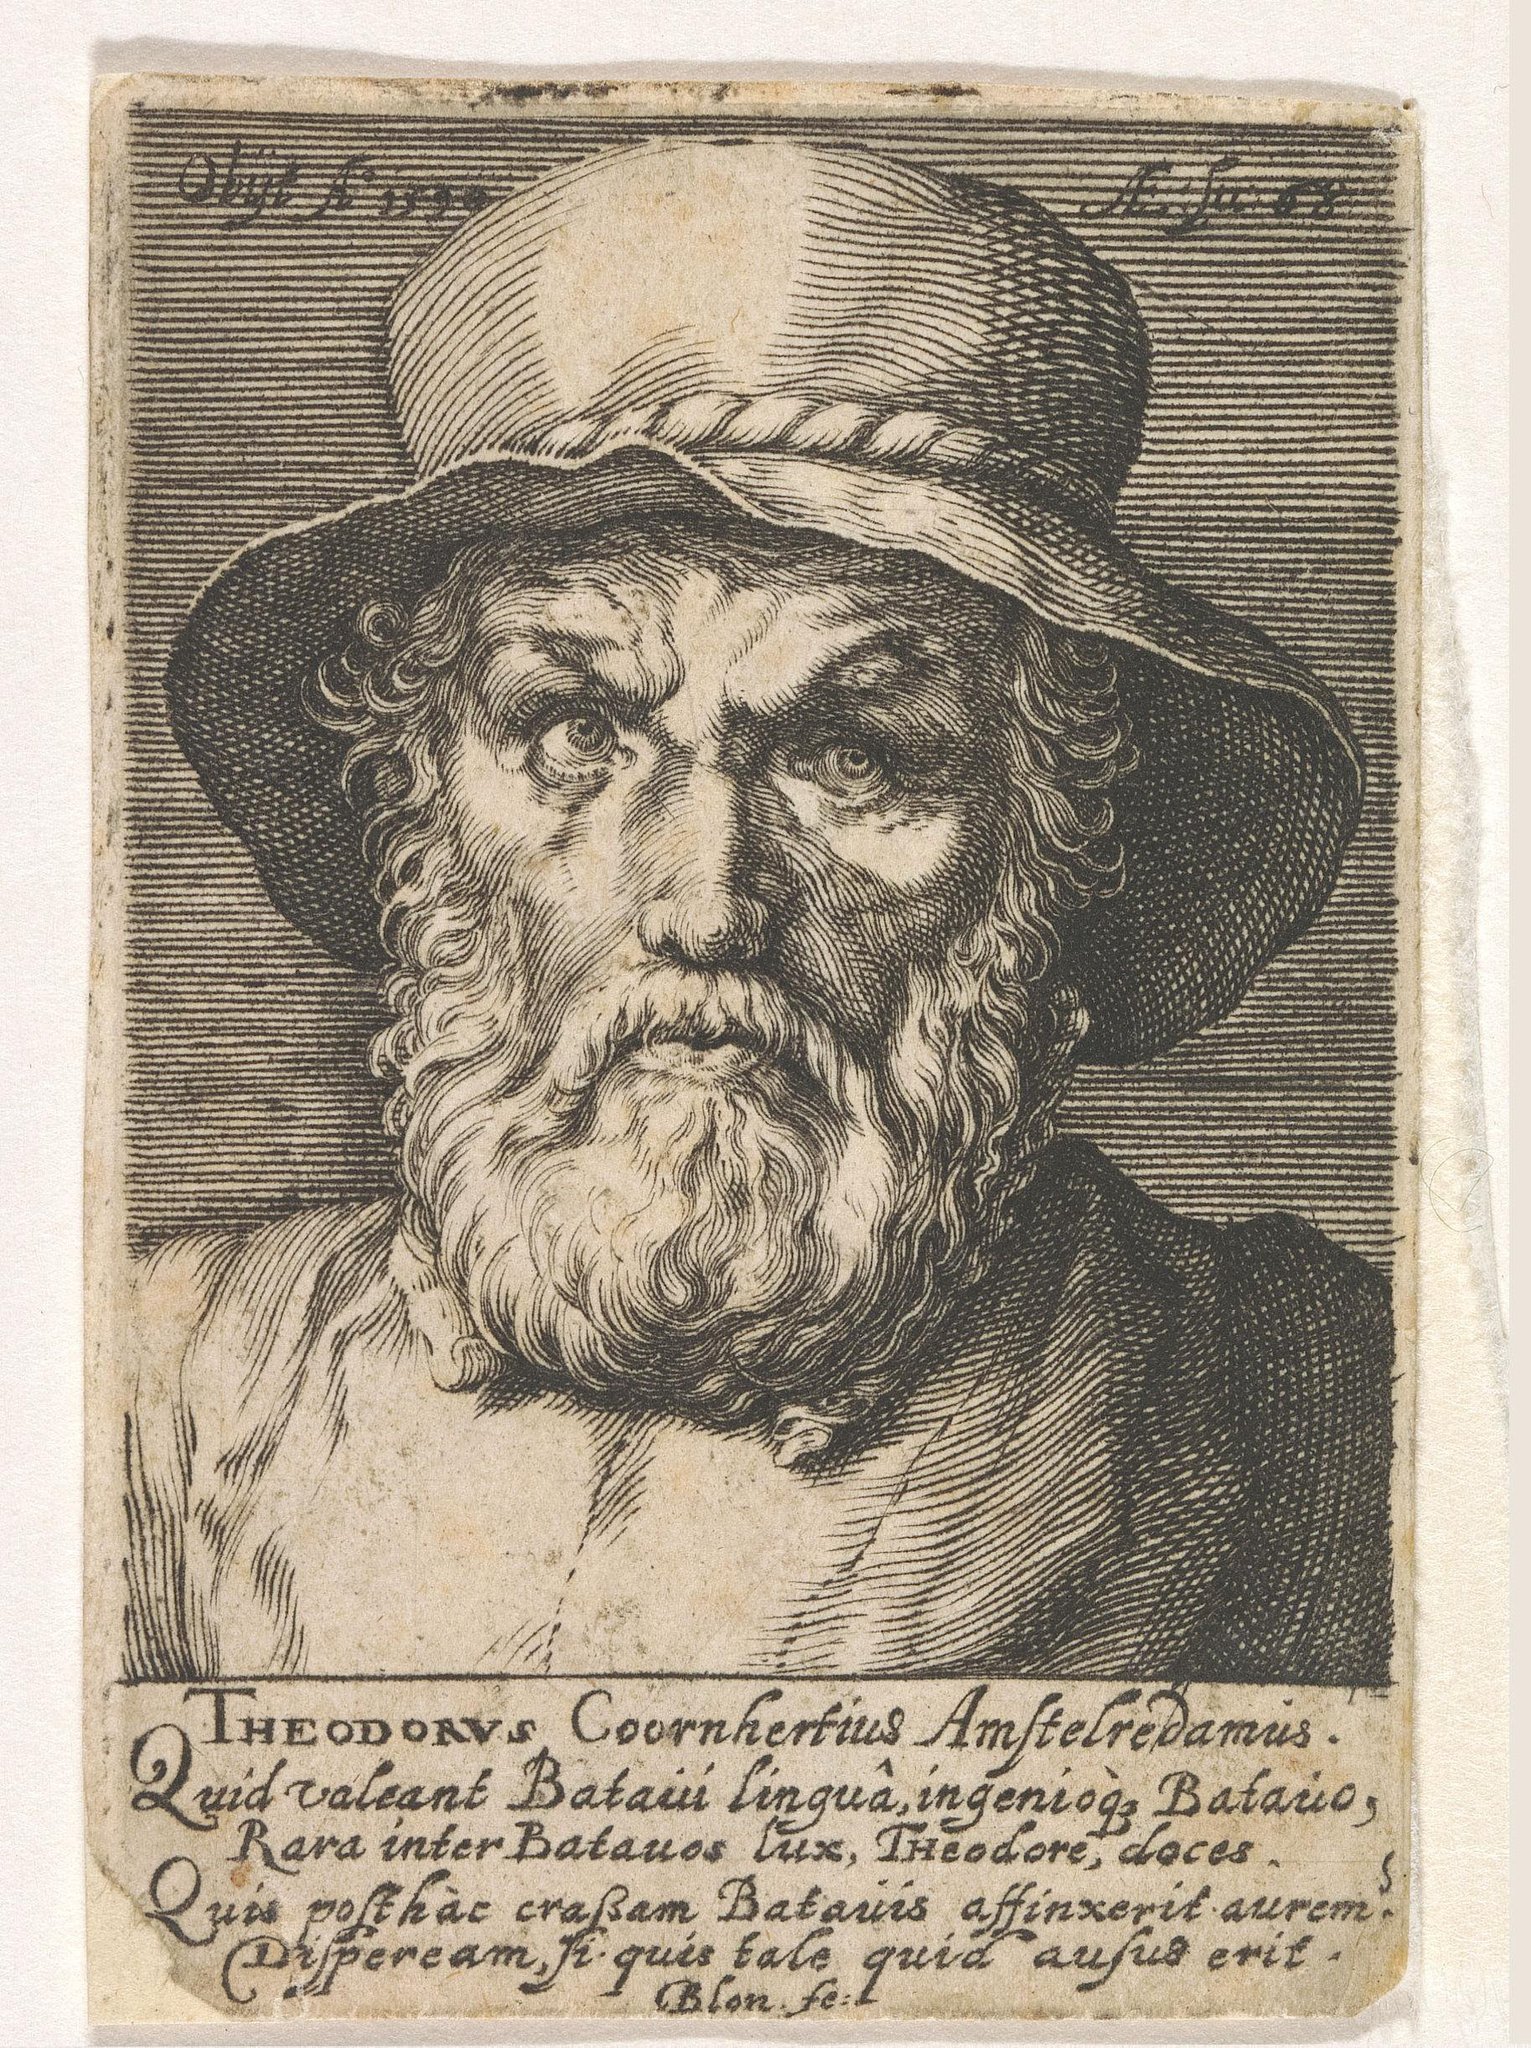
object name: print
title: Portret van Dirck Volckertsz. Coornhert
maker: michiel le blon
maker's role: print maker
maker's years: 1587-1656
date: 1590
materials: paper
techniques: engraving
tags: gouda, print maker, dirck volckertsz. coornhert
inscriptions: collector's mark: Lugt 2228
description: Portret opgenomen in: Coornhert, Dirck Volckertsz. Ethica. Zede-kunst dat is wel-levens kunste. Amsterdam: s.l.s.n. 1630.